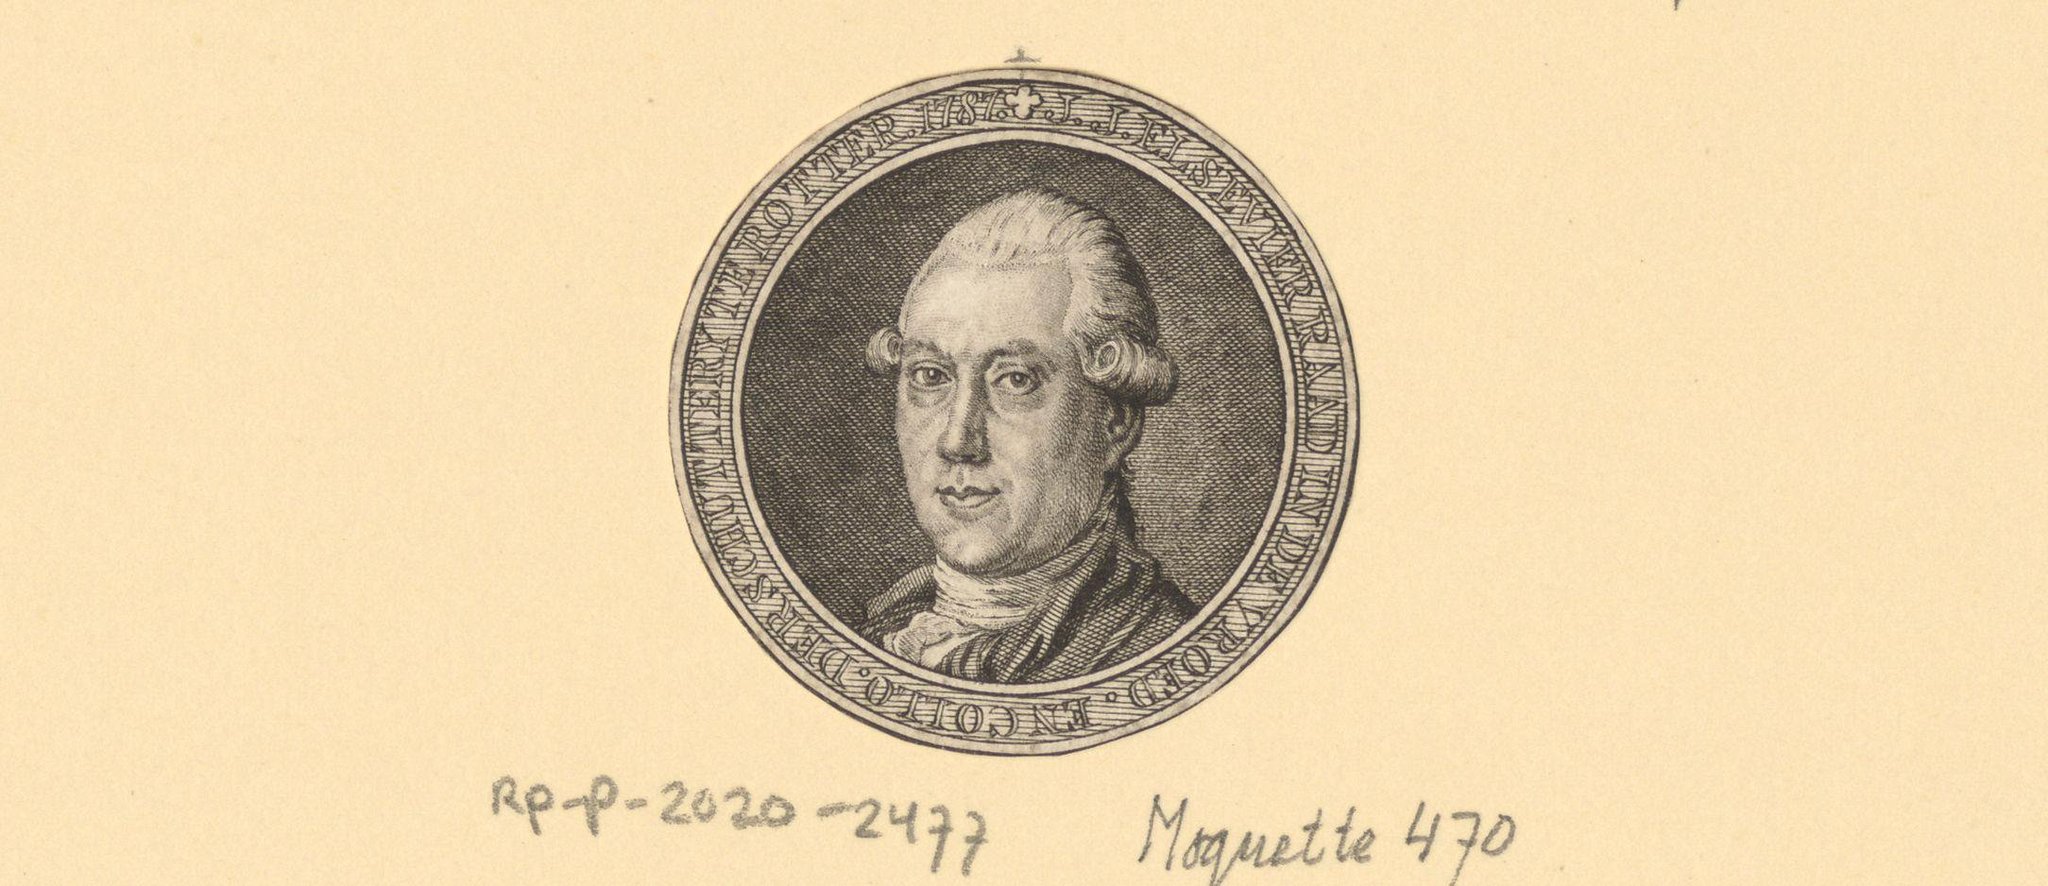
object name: print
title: Portretten van patriotten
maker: abraham jacobsz. hulk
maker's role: print maker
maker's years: 1751-1817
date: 1787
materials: paper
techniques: engraving, etching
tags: historical persons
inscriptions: date